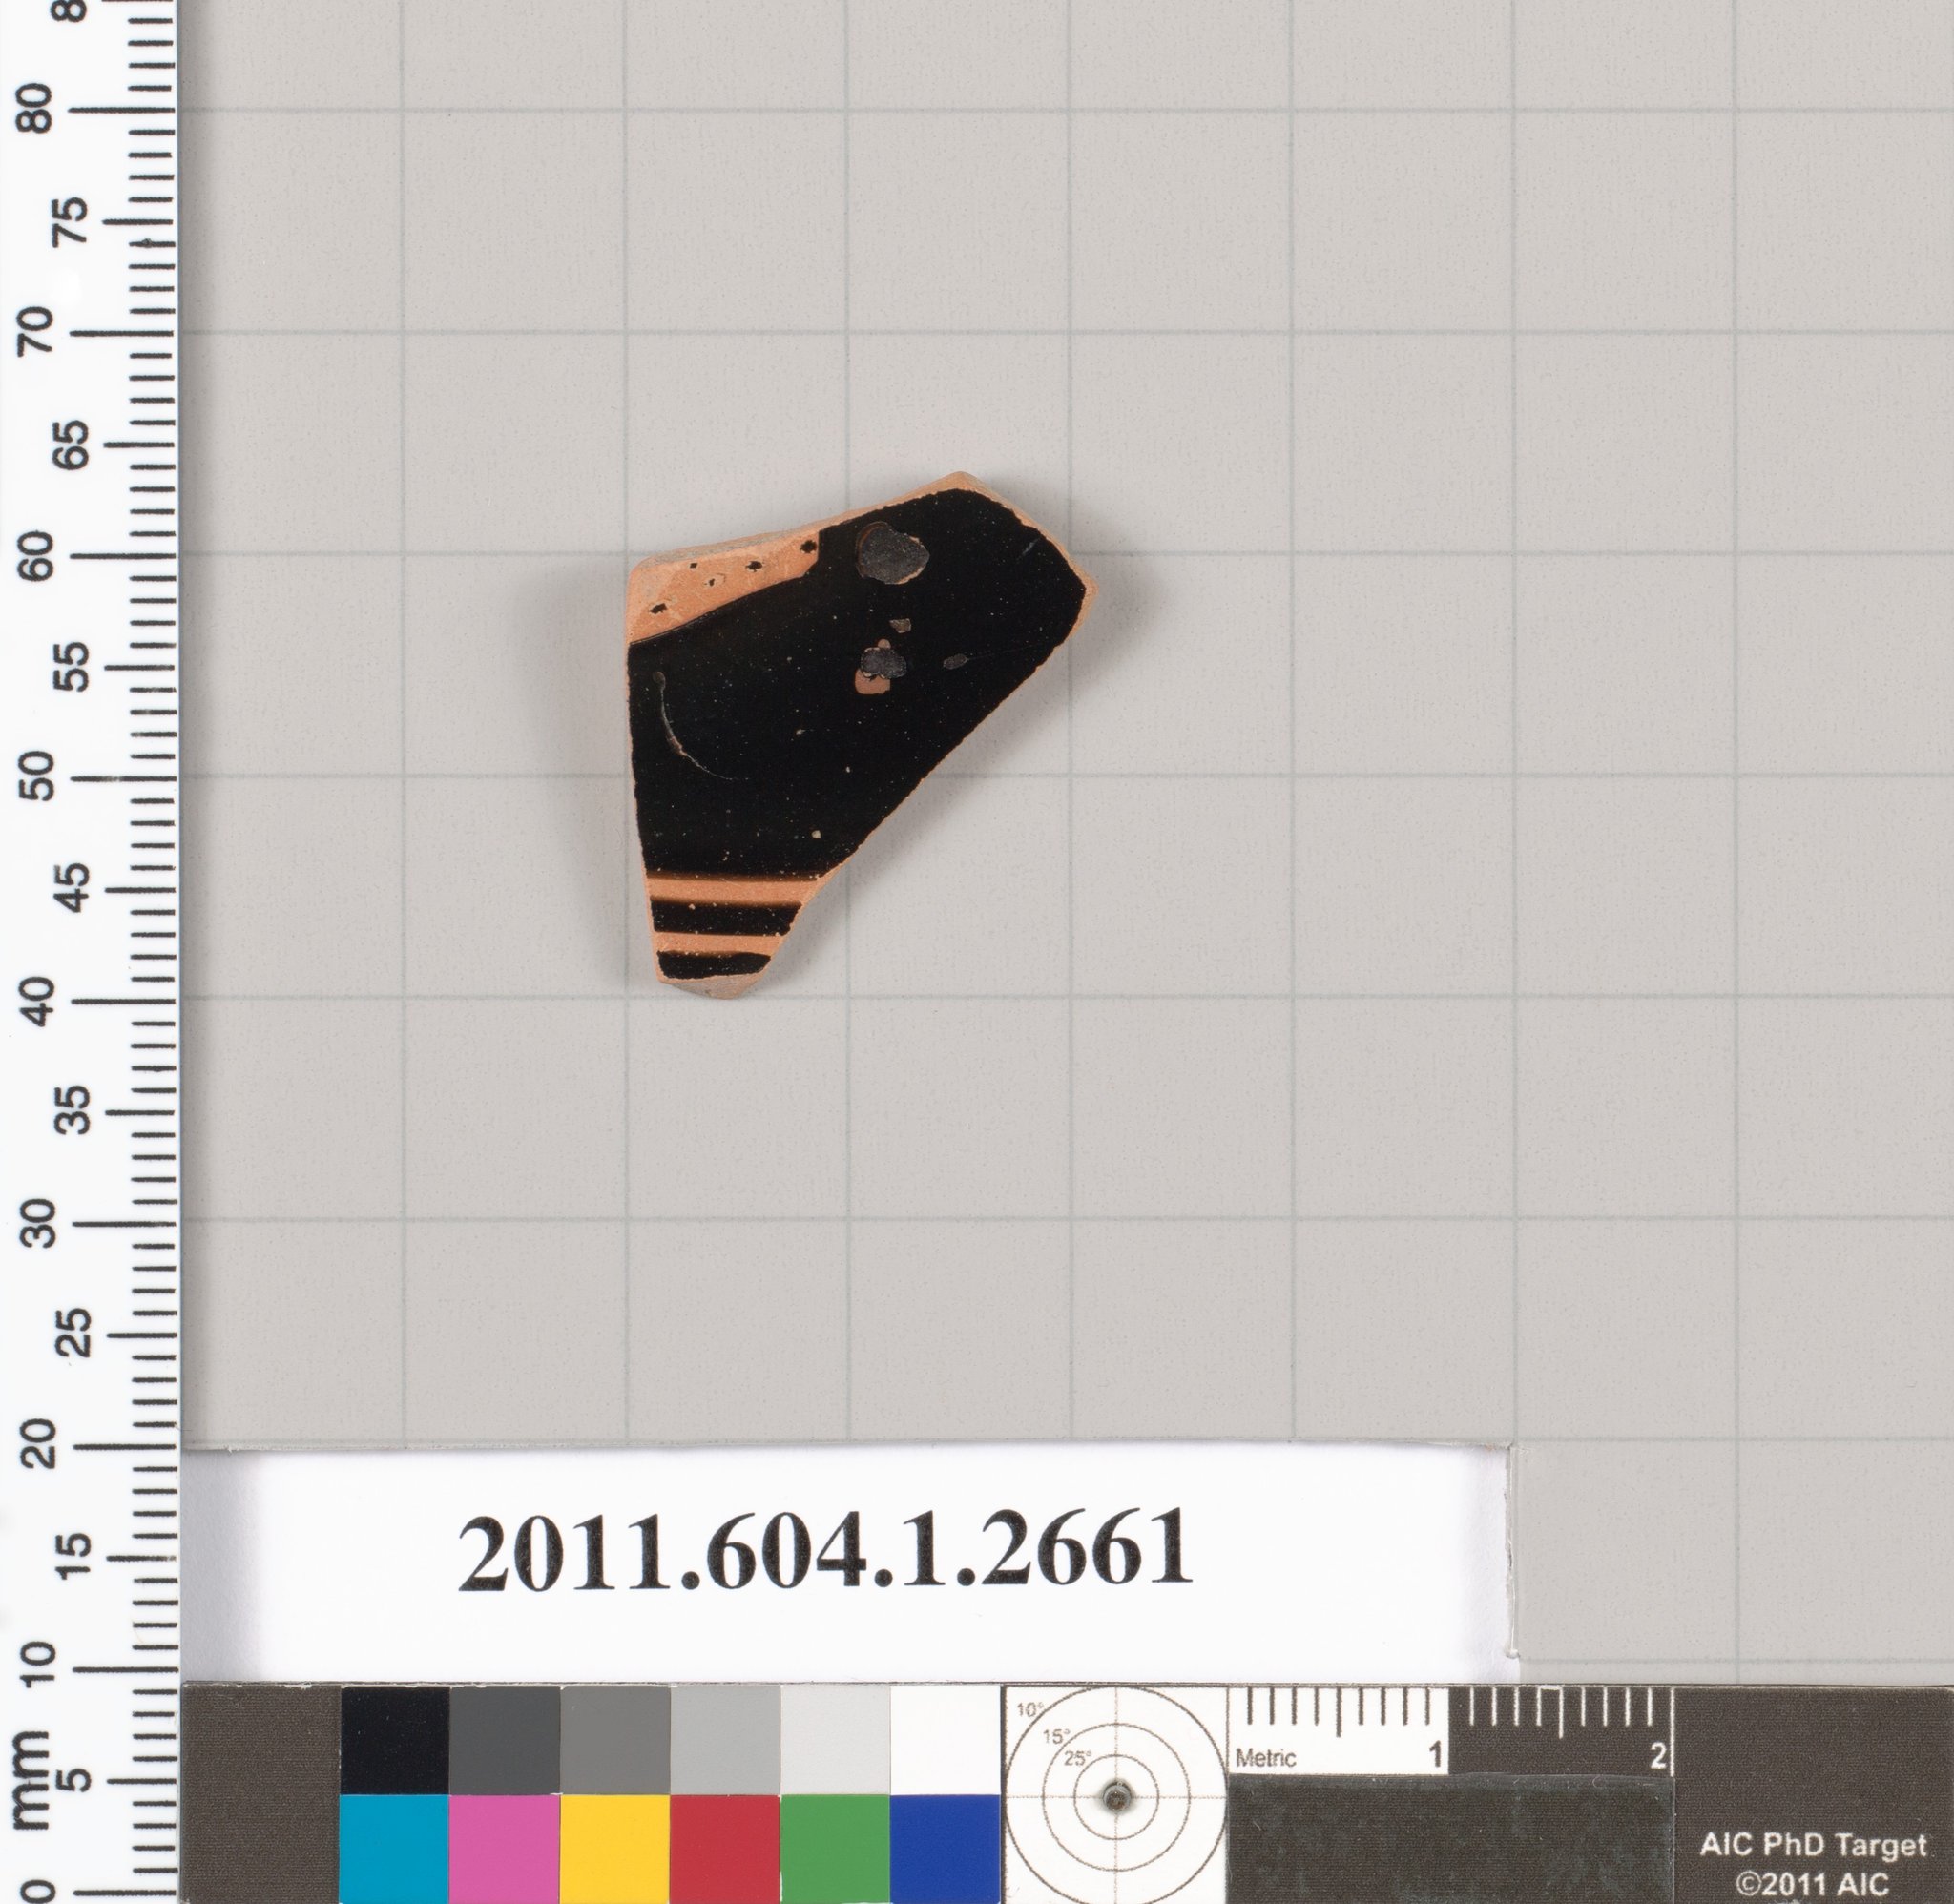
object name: kylix fragment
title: Terracotta fragment of a kylix (drinking cup)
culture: greek, attic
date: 500-451 BCE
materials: terracotta